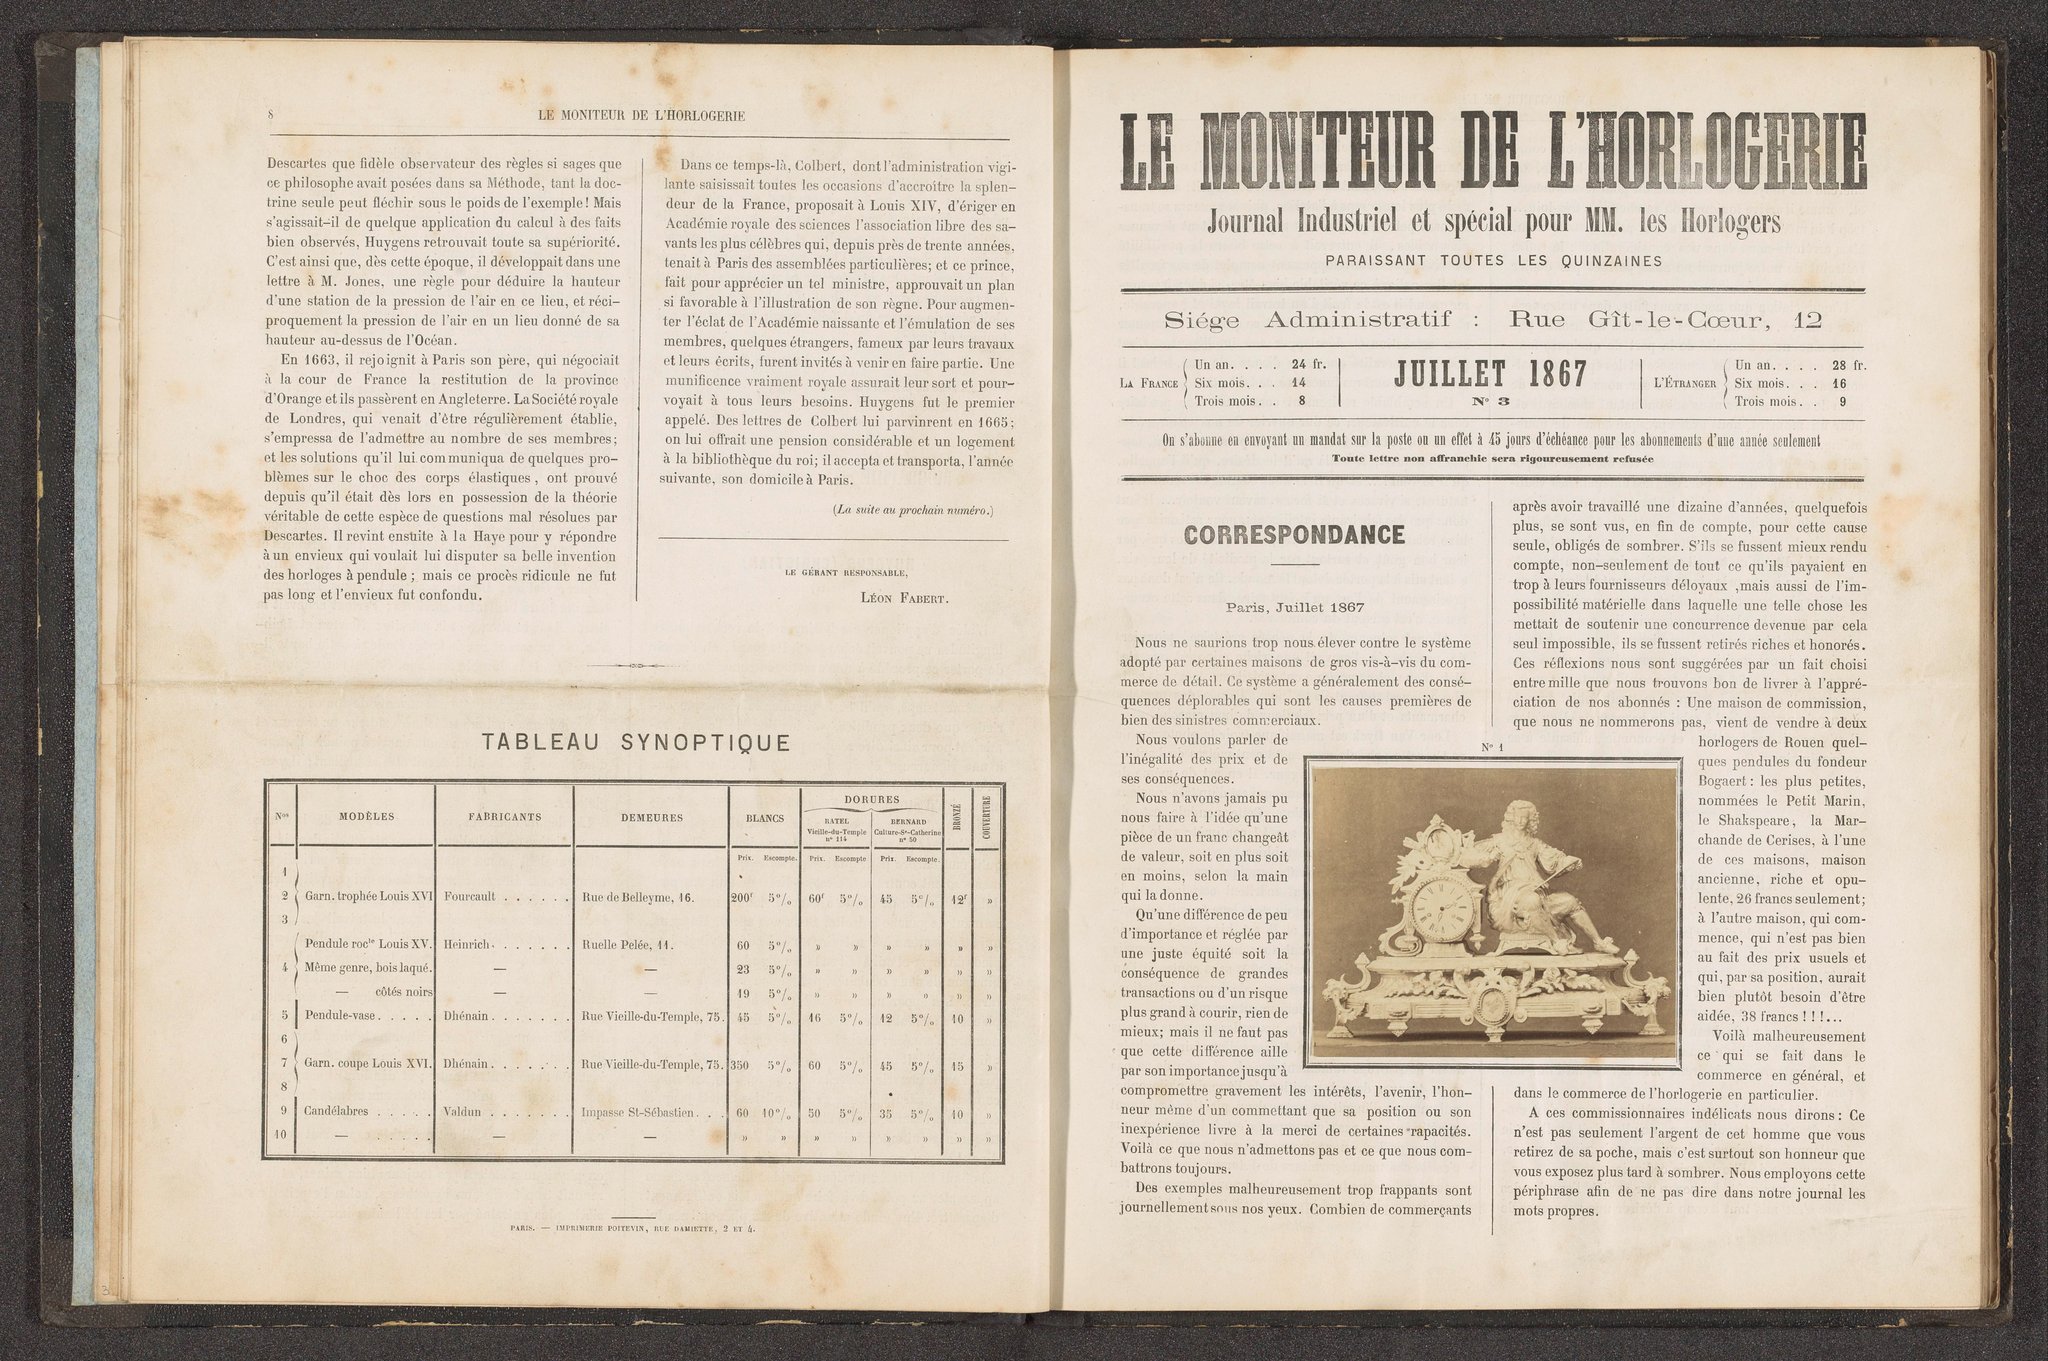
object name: photograph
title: Klok gedecoreerd met Antoon van Dyck door la Maison Pape et Compagnie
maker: Anonymous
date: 1857-1867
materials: photographic support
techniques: albumen print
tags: clock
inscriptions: number: ‘No 1’